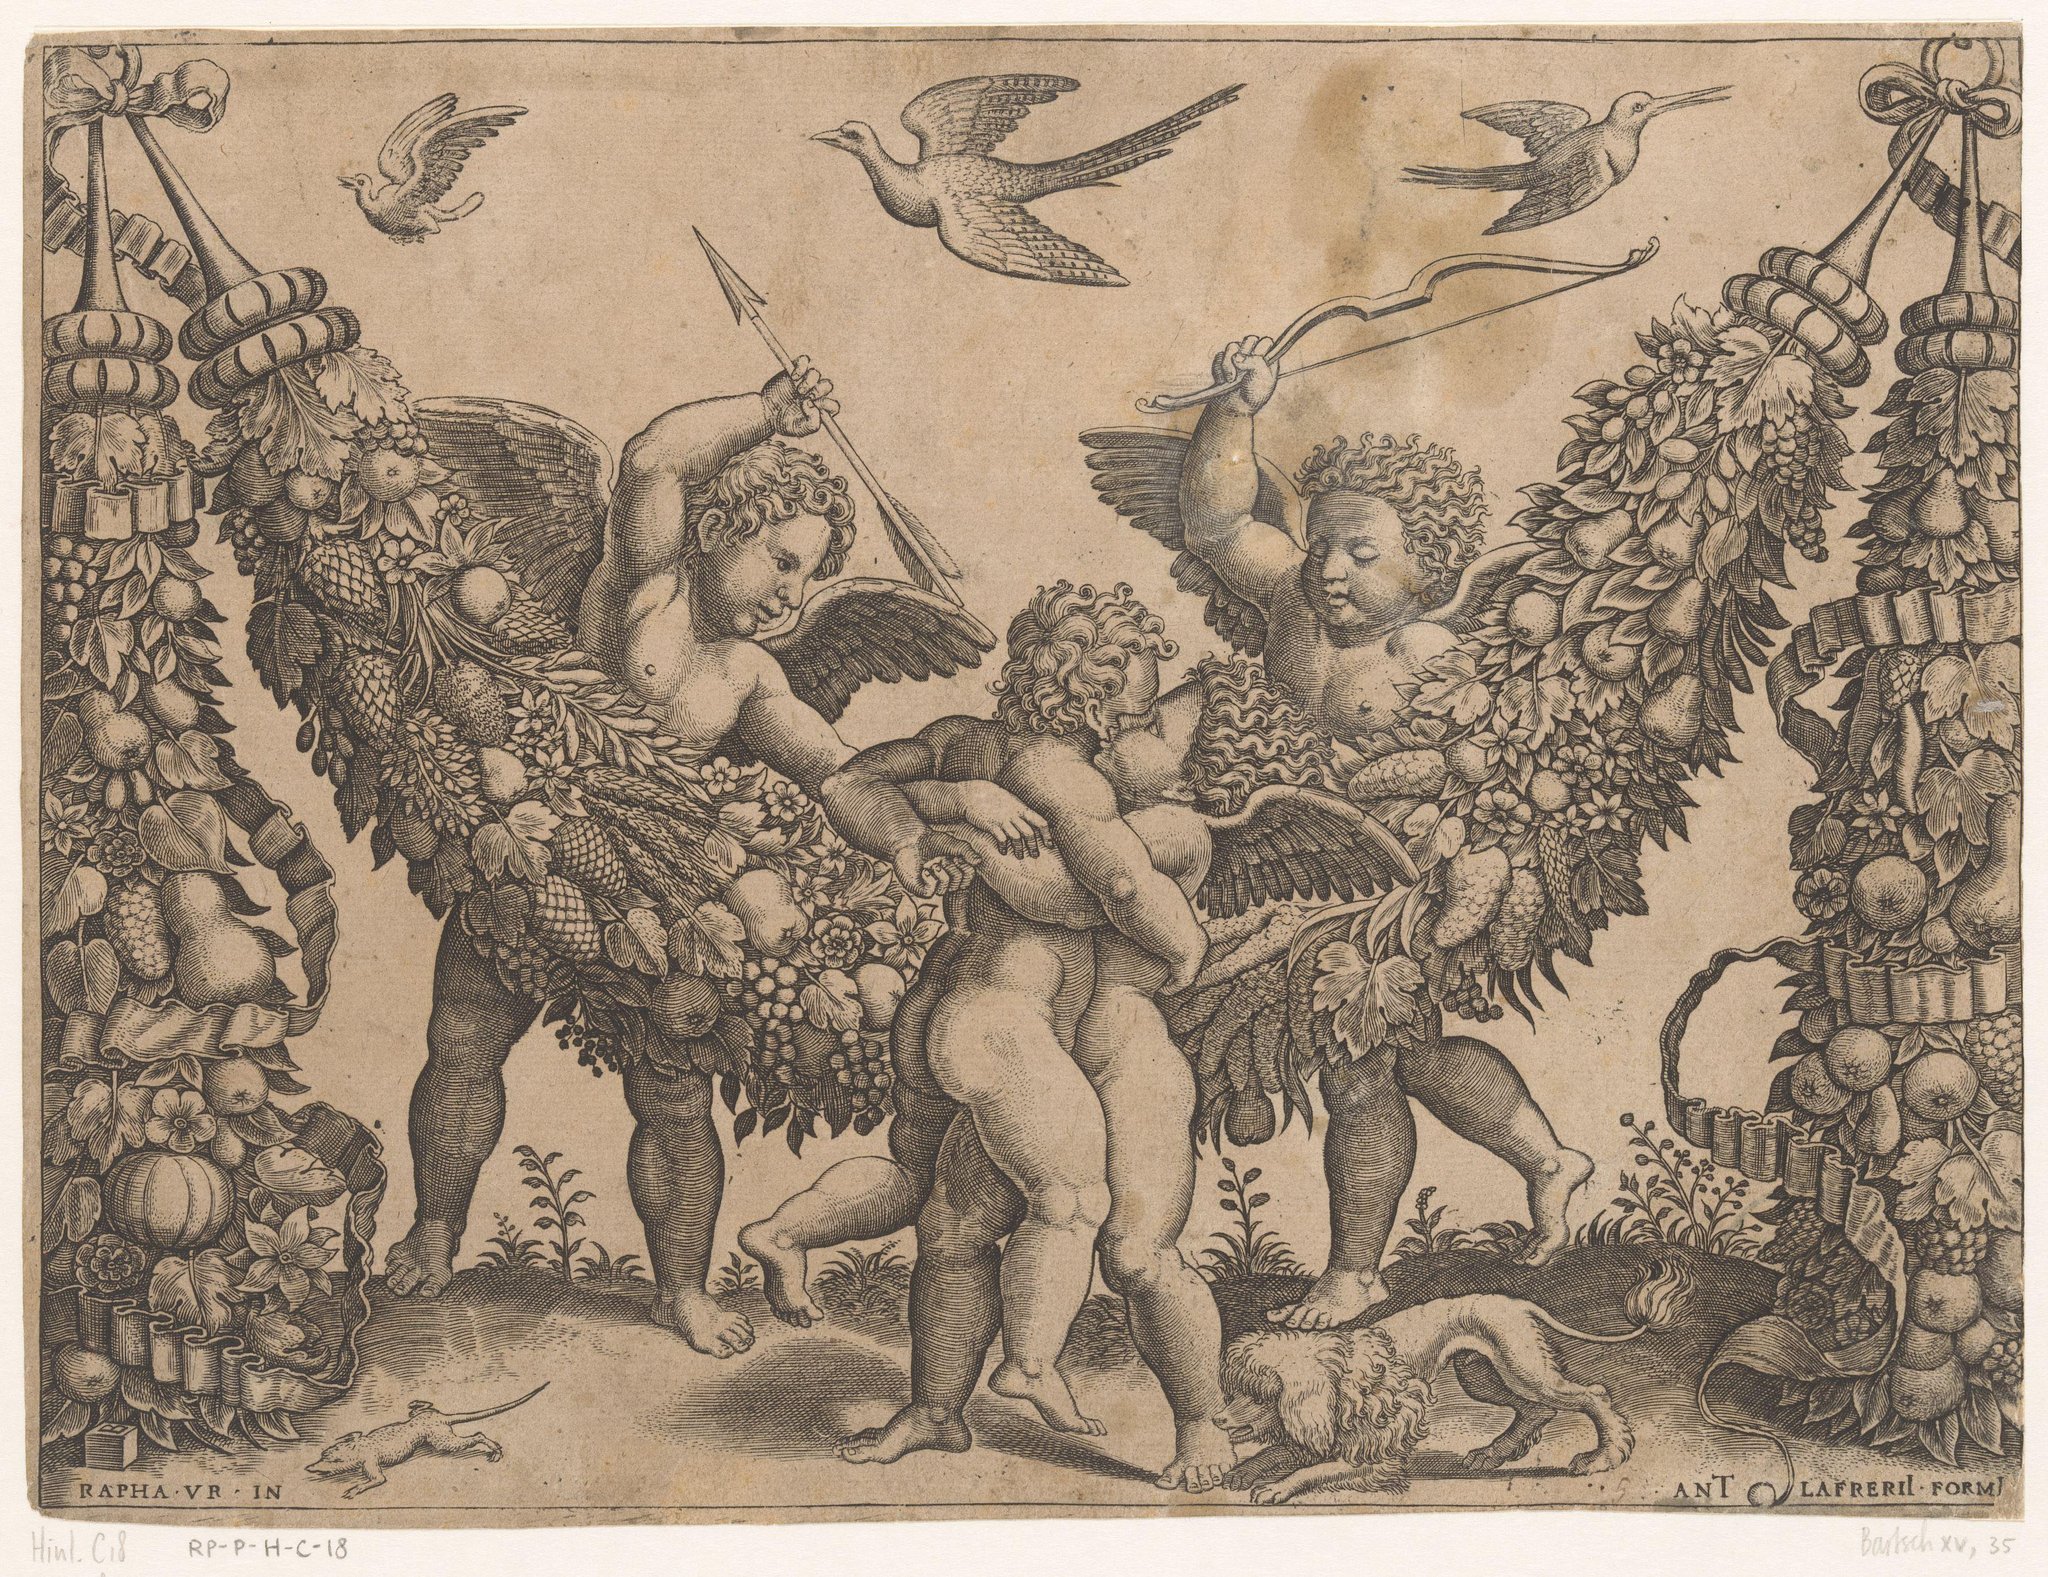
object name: print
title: Tapisserieën van de paus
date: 1530-1560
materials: paper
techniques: engraving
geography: rome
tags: cupids: 'amores', 'amoretti', 'putti', dog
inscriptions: collector's mark: Lugt 11, collector's mark: ‘Hinloopen’, collector's mark: Lugt 10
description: Voor een grote guirlande tilt een putto een kind op. Achter de guirlande twee putti met pijl-en-boog. In de lucht drie vogels en op de voorgrond een hond.